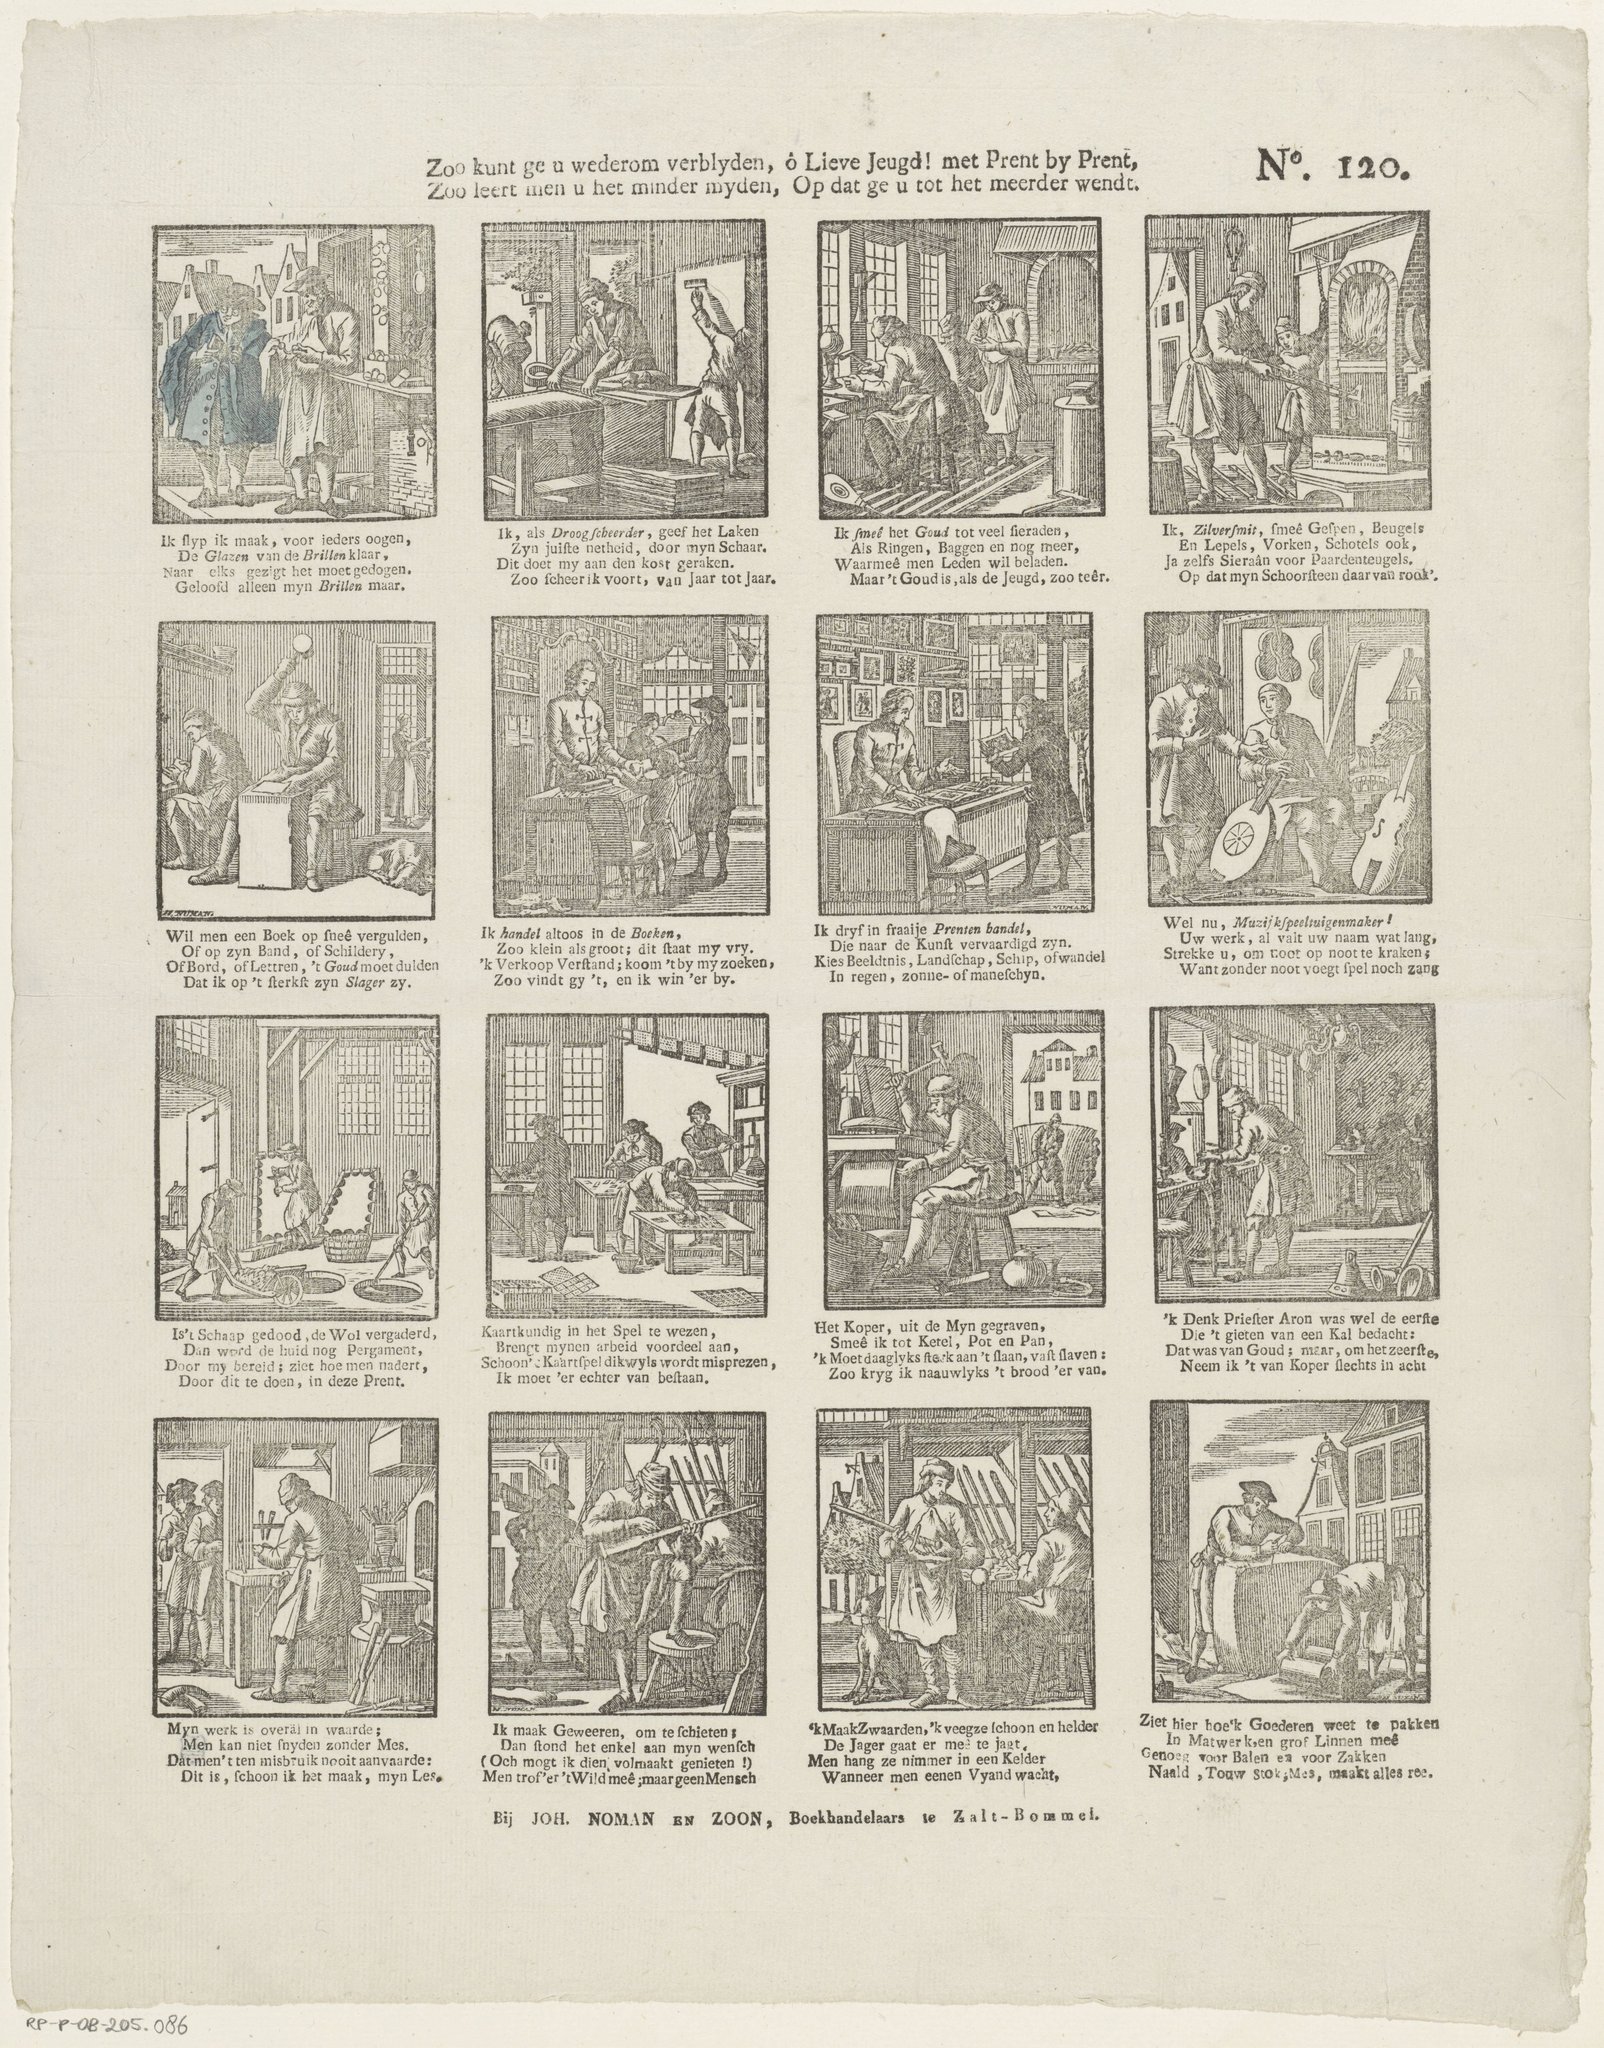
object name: print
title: Zoo kunt ge u wederom verblyden, ô lieve jeugd! met prent, / Zoo leert men u het minder myden, Op dat ge u tot het meerder wendt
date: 1830-1892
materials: paper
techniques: colour, letterpress printing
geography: zaltbommel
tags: craft-production, skilled handiwork, jeweller, goldsmith, silversmith, street-trader, crafts and industries, merchant, salesman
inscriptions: collector's mark: Lugt 2760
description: Blad met 16 voorstellingen van ambachtsliedenen beroepen, zoals een brillenverkoper, een goudsmid en een gewerenmaker. Onder elke afbeelding een vierregelig vers. Genummerd rechtsboven: No. 120.